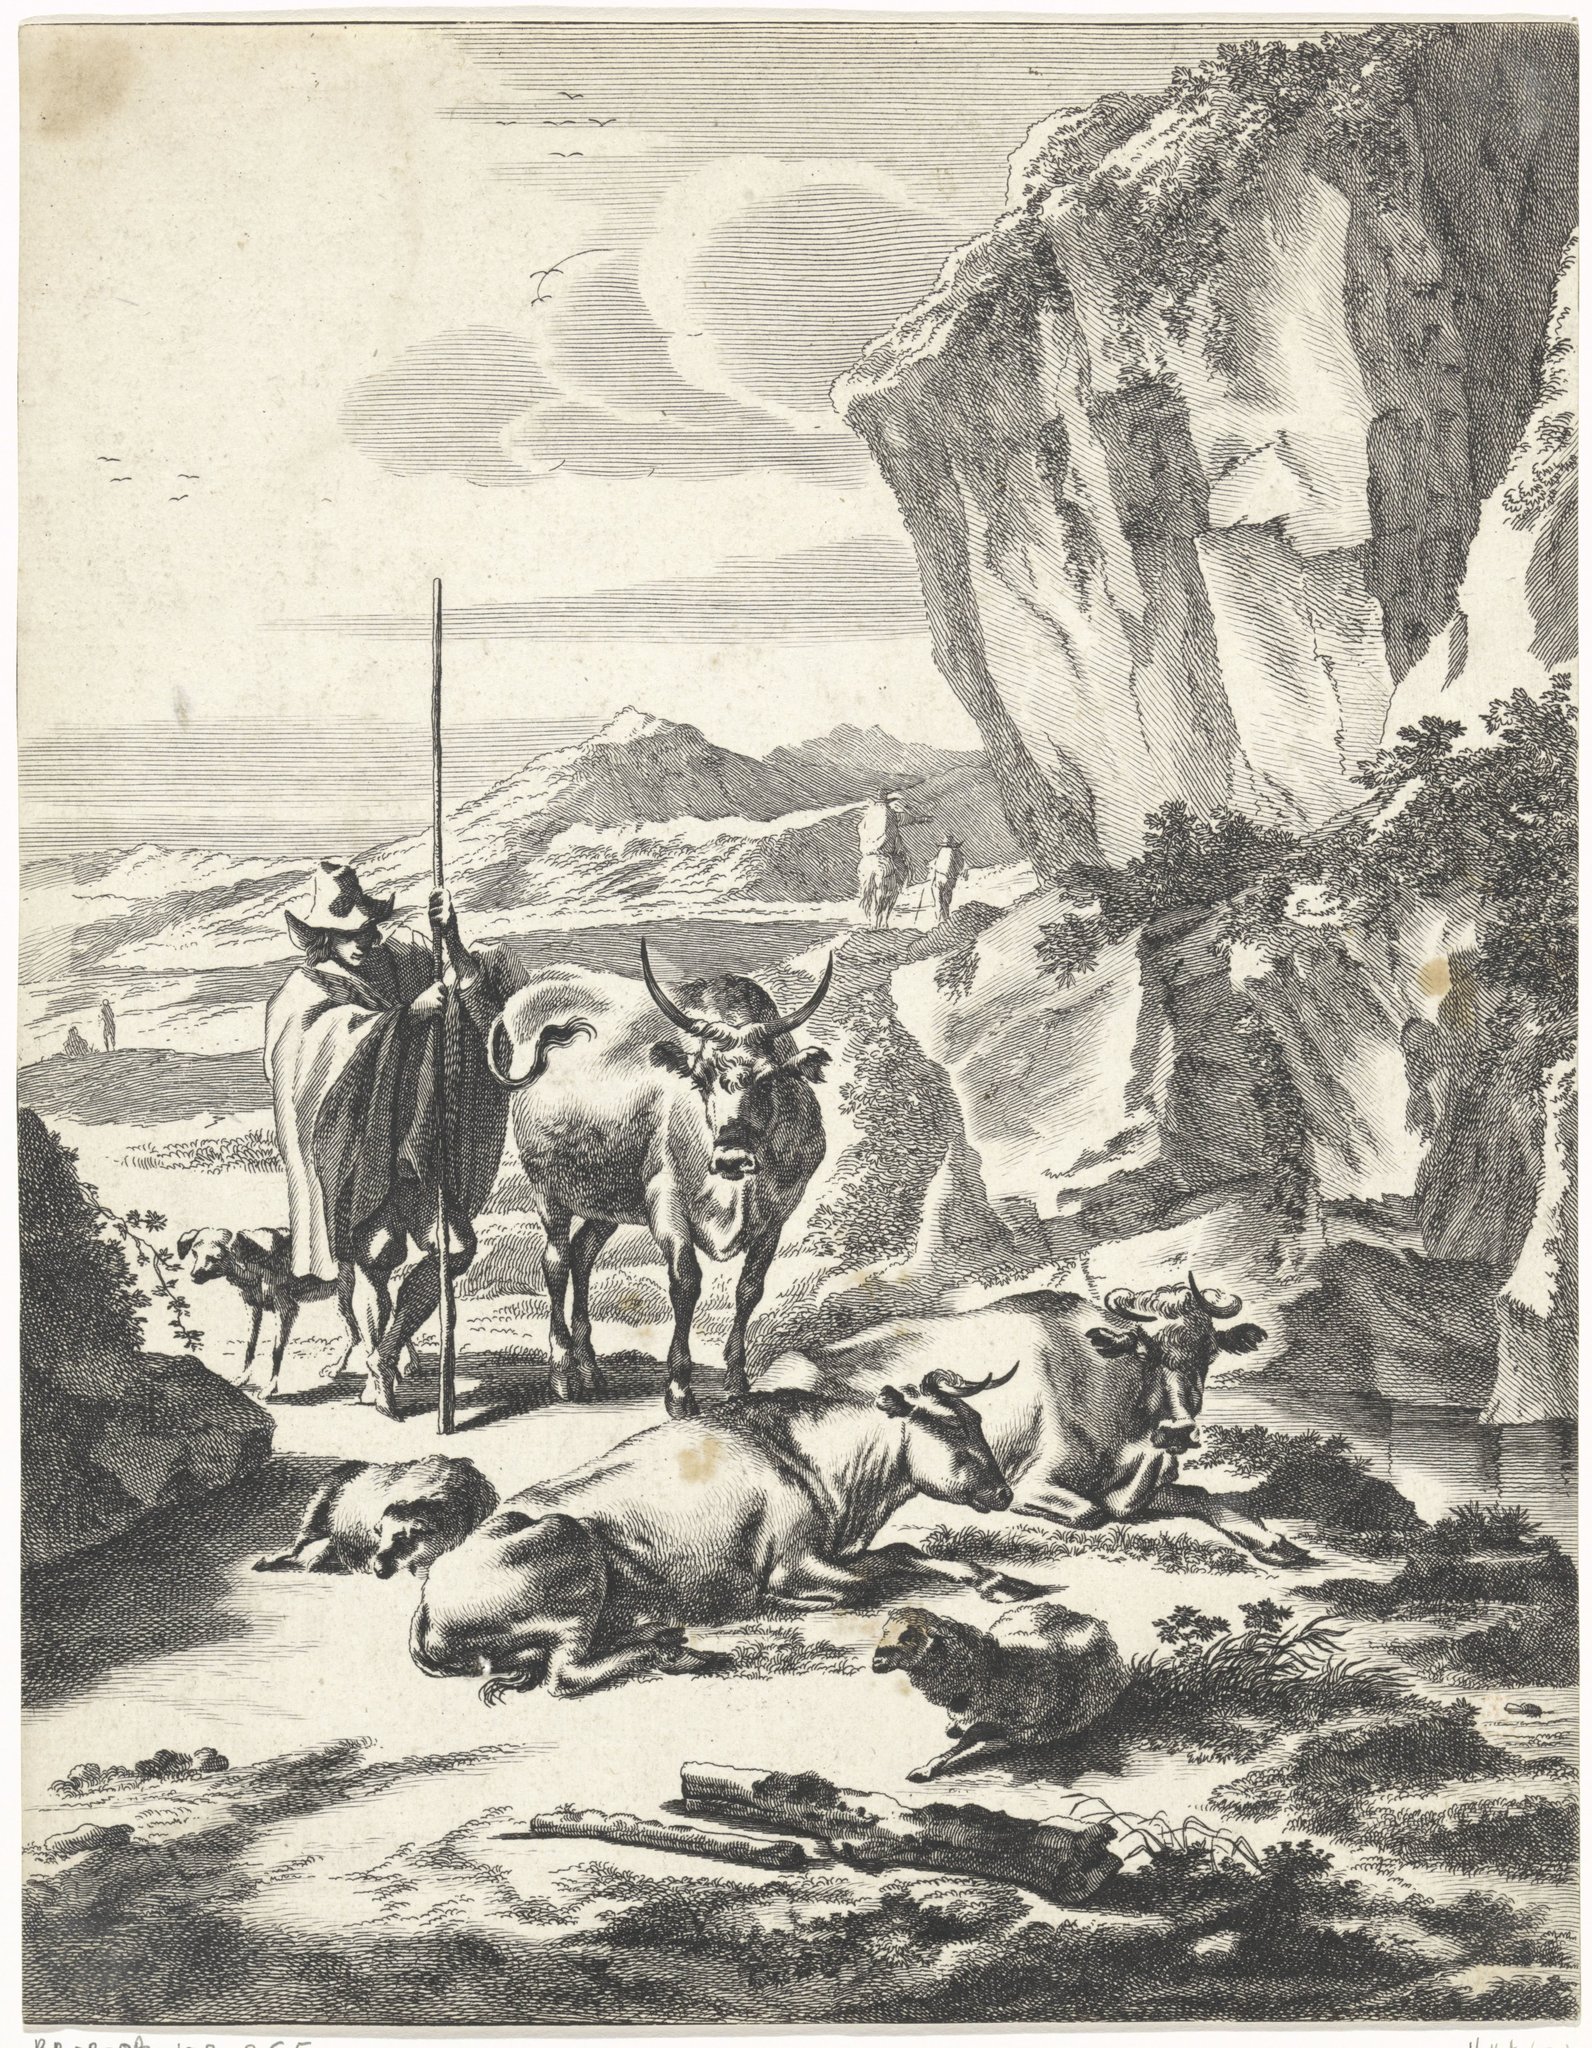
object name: print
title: Rotsachtig landschap met een herder en zijn kudde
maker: jan de visscher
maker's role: print maker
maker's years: 1633-1712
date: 1650-1701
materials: paper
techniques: engraving, etching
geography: northern netherlands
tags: cow, herding, herdsman, herdswoman, shepherd, shepherdess, cowherd, etc., rocks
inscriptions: collector's mark: Lugt 2228